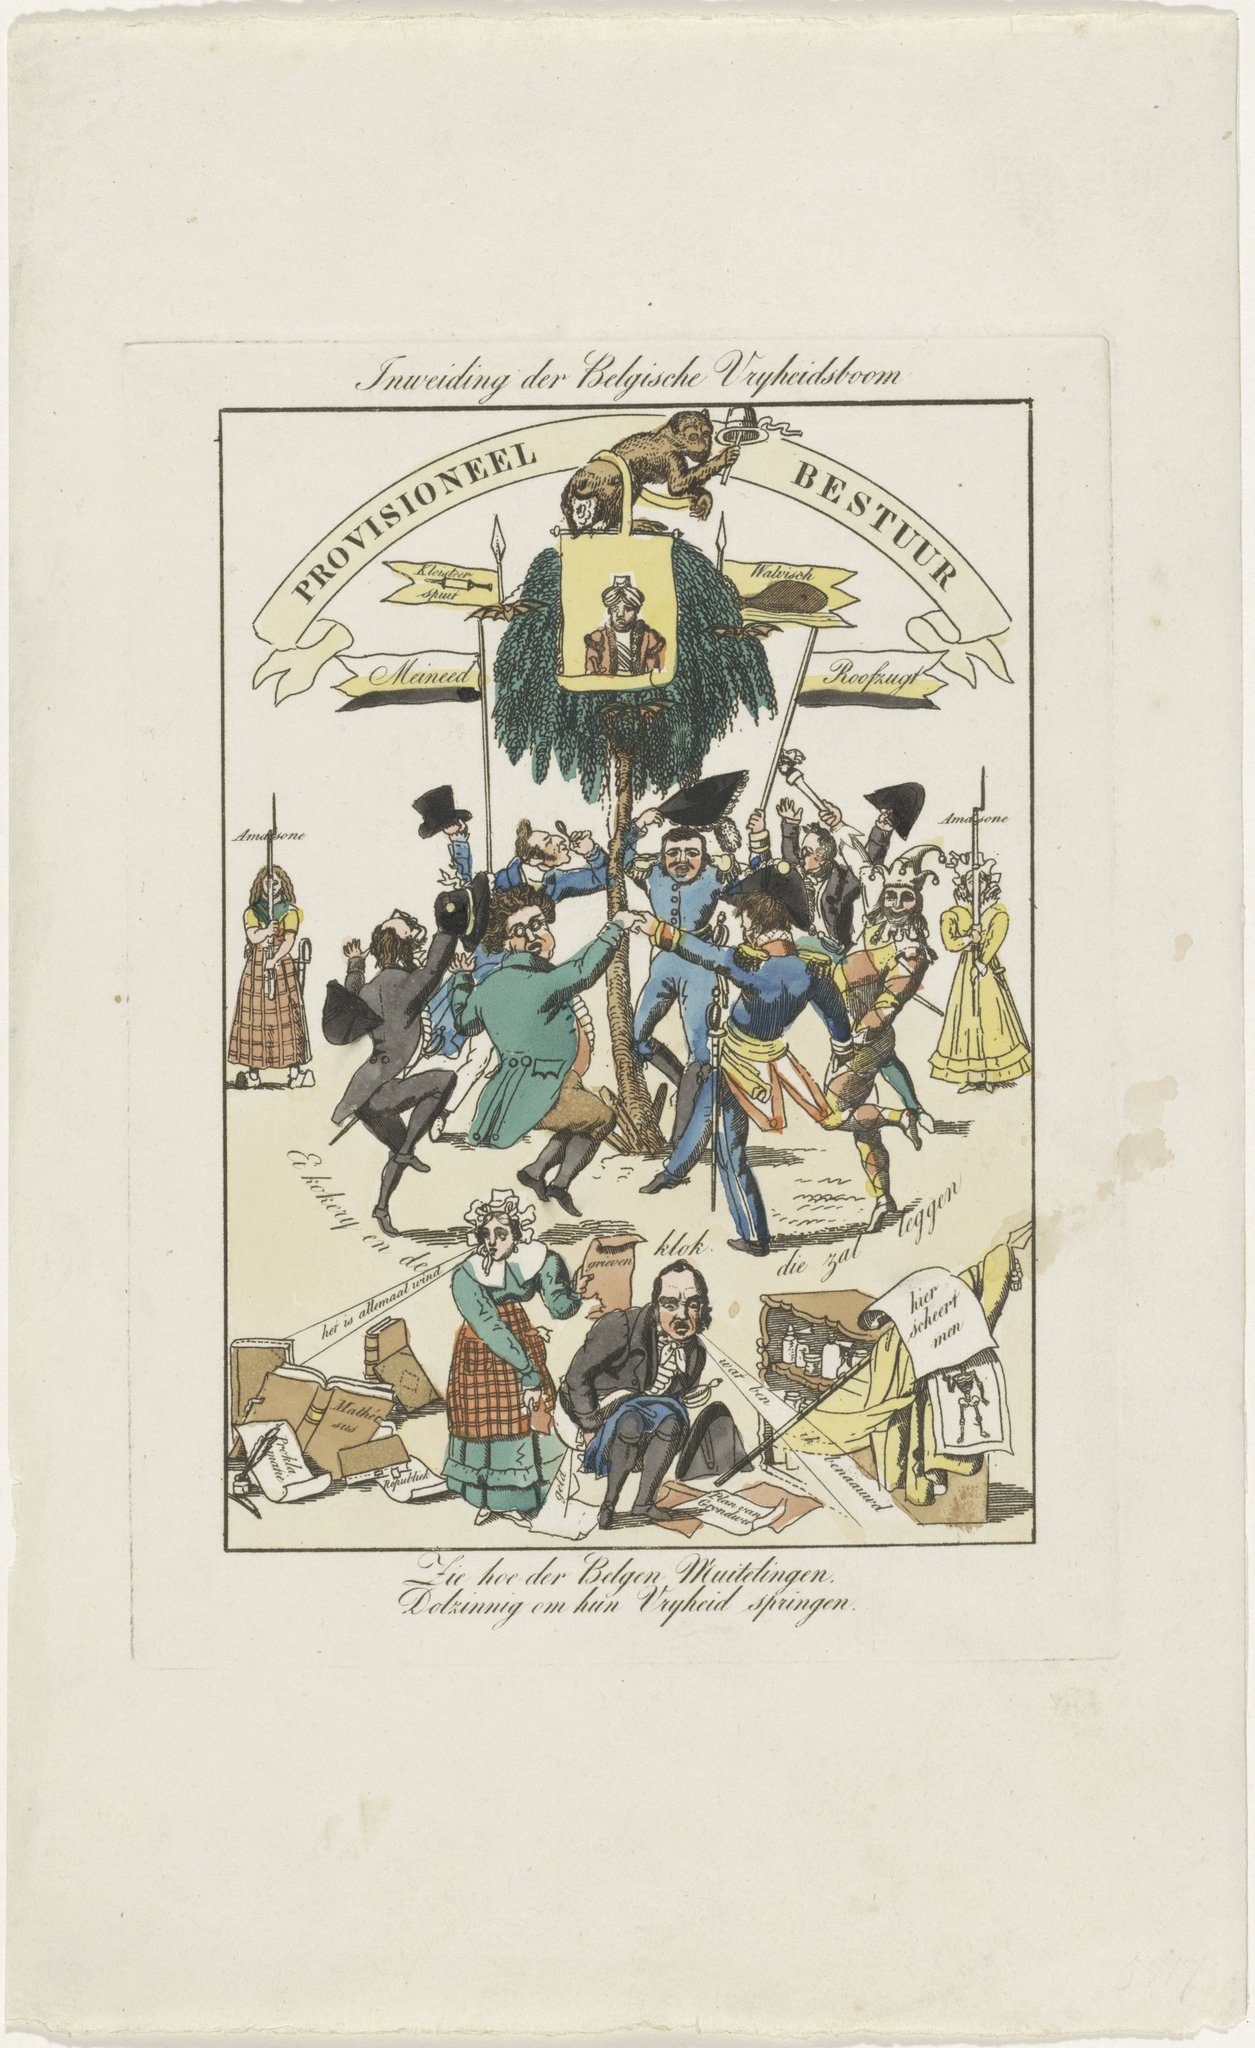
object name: cartoon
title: Belgische Vrijheidsboom, 1830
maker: Anonymous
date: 1830-1831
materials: paper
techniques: etching, hand coloring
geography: netherlands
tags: bruges, politician, flatulence, monkeys, apes, dancing around the tree of liberty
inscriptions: collector's mark: Lugt 2228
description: Spotprent op de aanstelling van het Voorlopig Bewind en het uitroepen van de Belgische onafhankelijkheid, 1830. De leden van het Voorlopig Bewind dansen om de vrijheidsboom waar bovenin een aap zit met ontbloot achterwerk. Om het achterwerk van de aap hangt een portret van een Turk of Arabier. Links en rechts posten vrouwelijke vrijwilligers met geweer. Op de voorgrond hurkt De Potter met de broek om de enkels en probeert zich te ontlasten, een meid reikt hem een papiertje aan en zegt 'het is allemaal wind'.